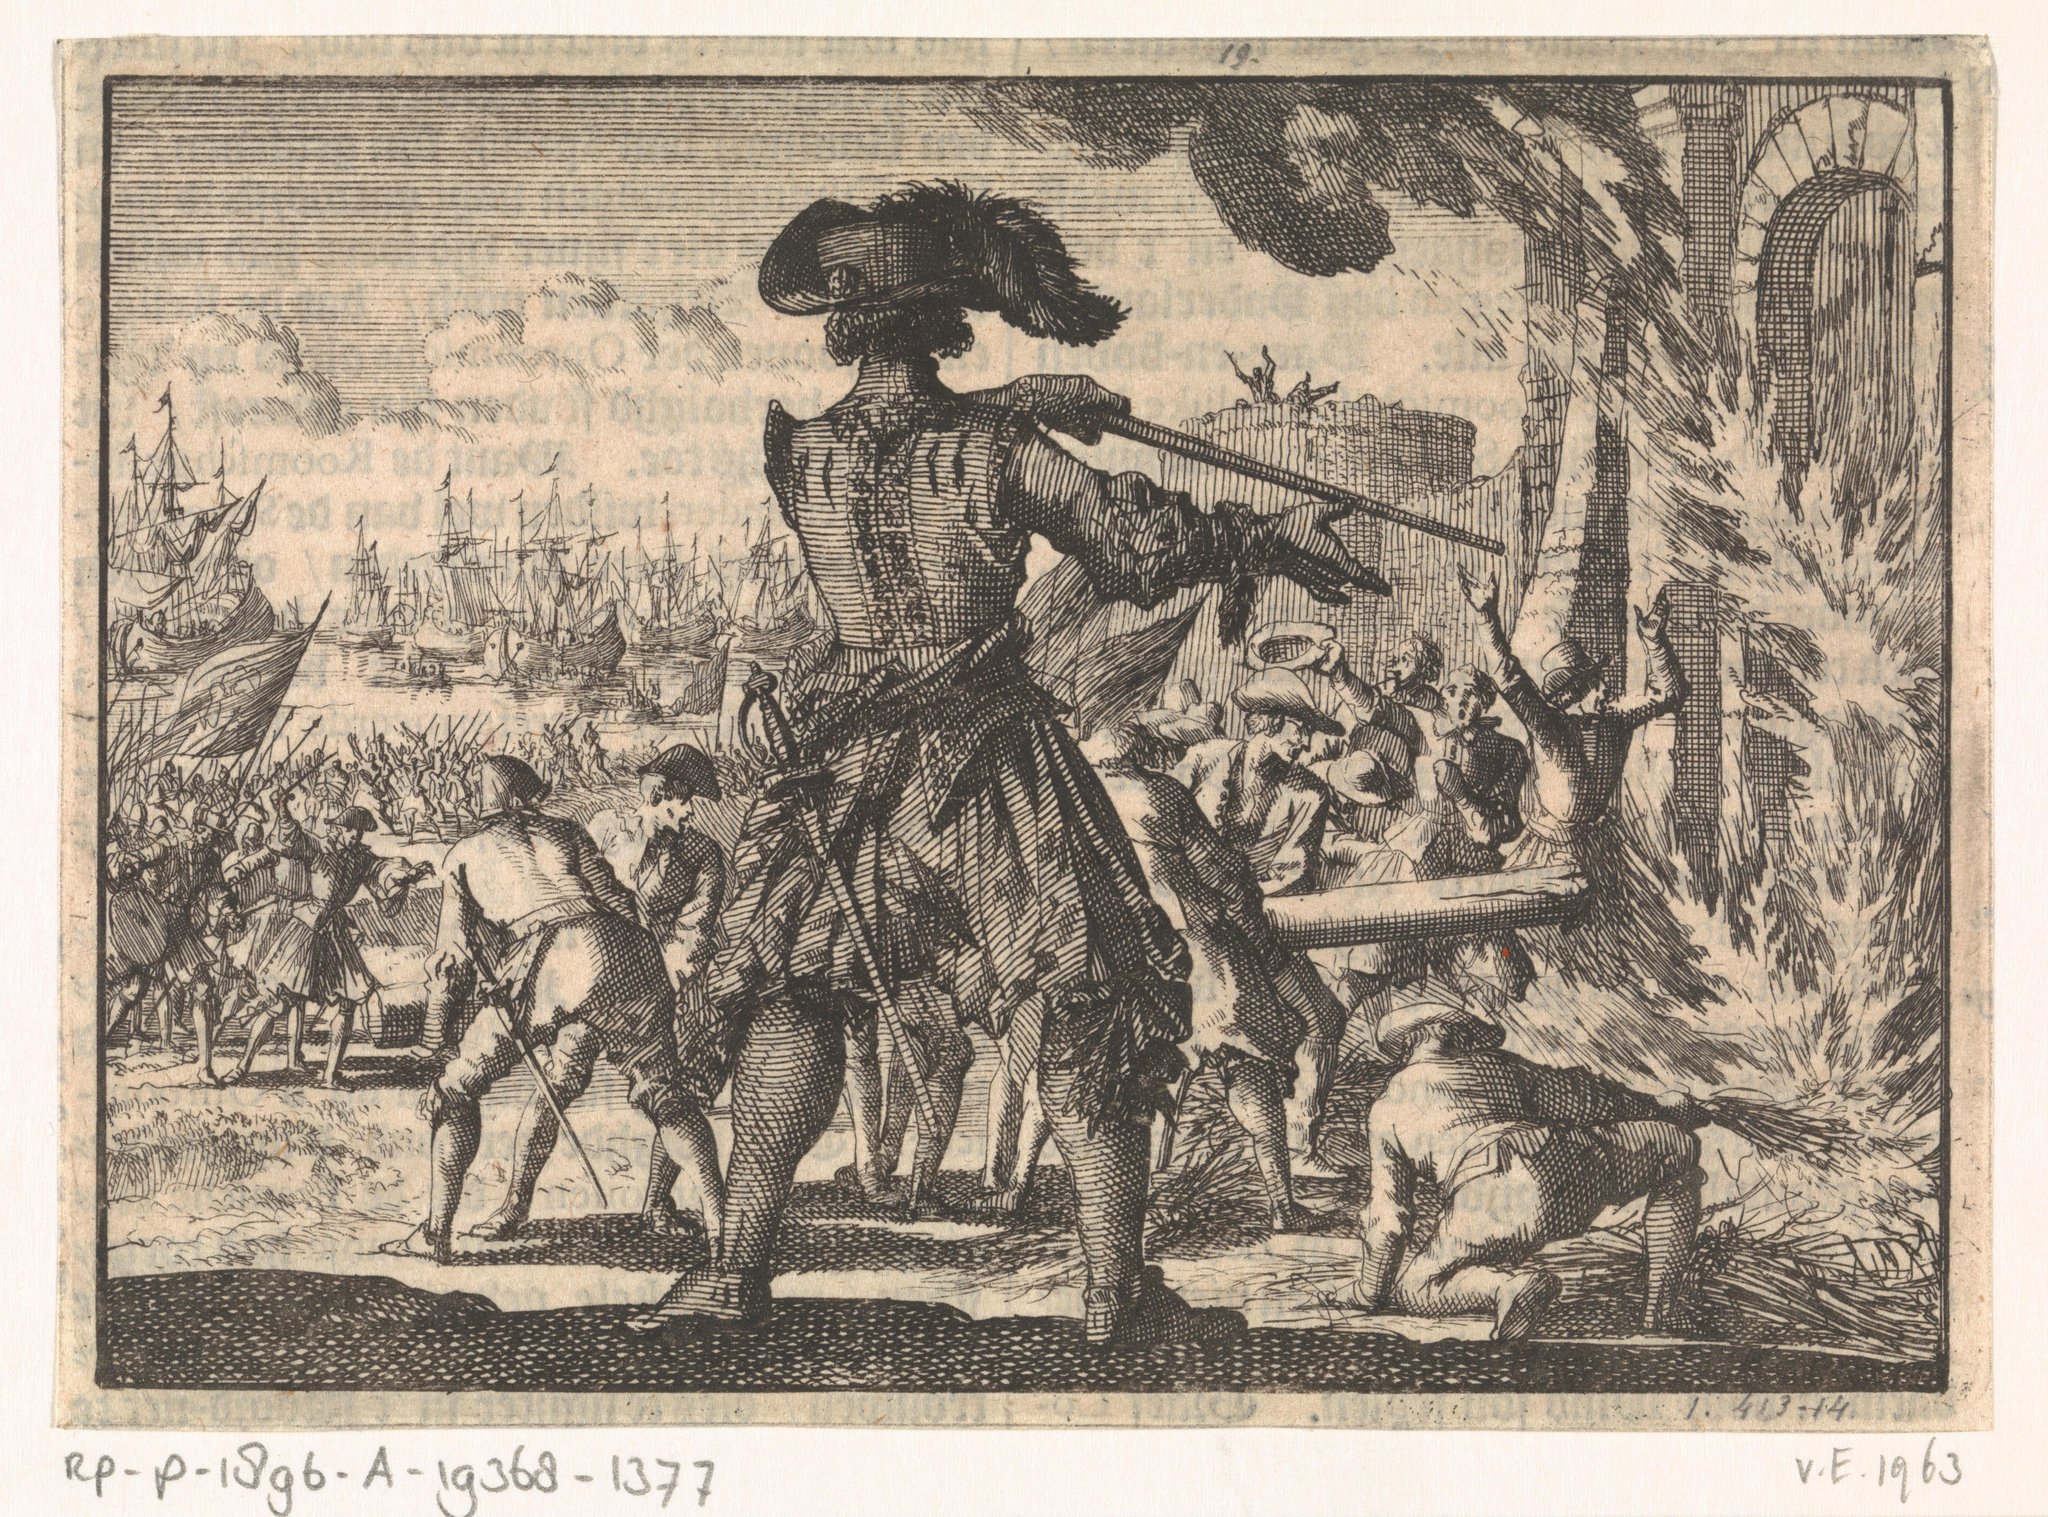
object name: print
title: Inname van Den Briel, 1572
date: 1698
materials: paper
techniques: etching, letterpress printing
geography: leiden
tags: capture of city (after the siege), brielle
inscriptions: collector's mark: Lugt 2228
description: Illustratie uit: Gottfried, Johann Ludwig. Historische kronyck; vervattende een (...) beschrijvingh der aldergedenckwaerdigste geschiedenissen des weerelds, van den aenvangh der scheppingh tot (...) 1576 (2 delen). Leiden: Pieter van der Aa, 1698, dl. I, p. 413.